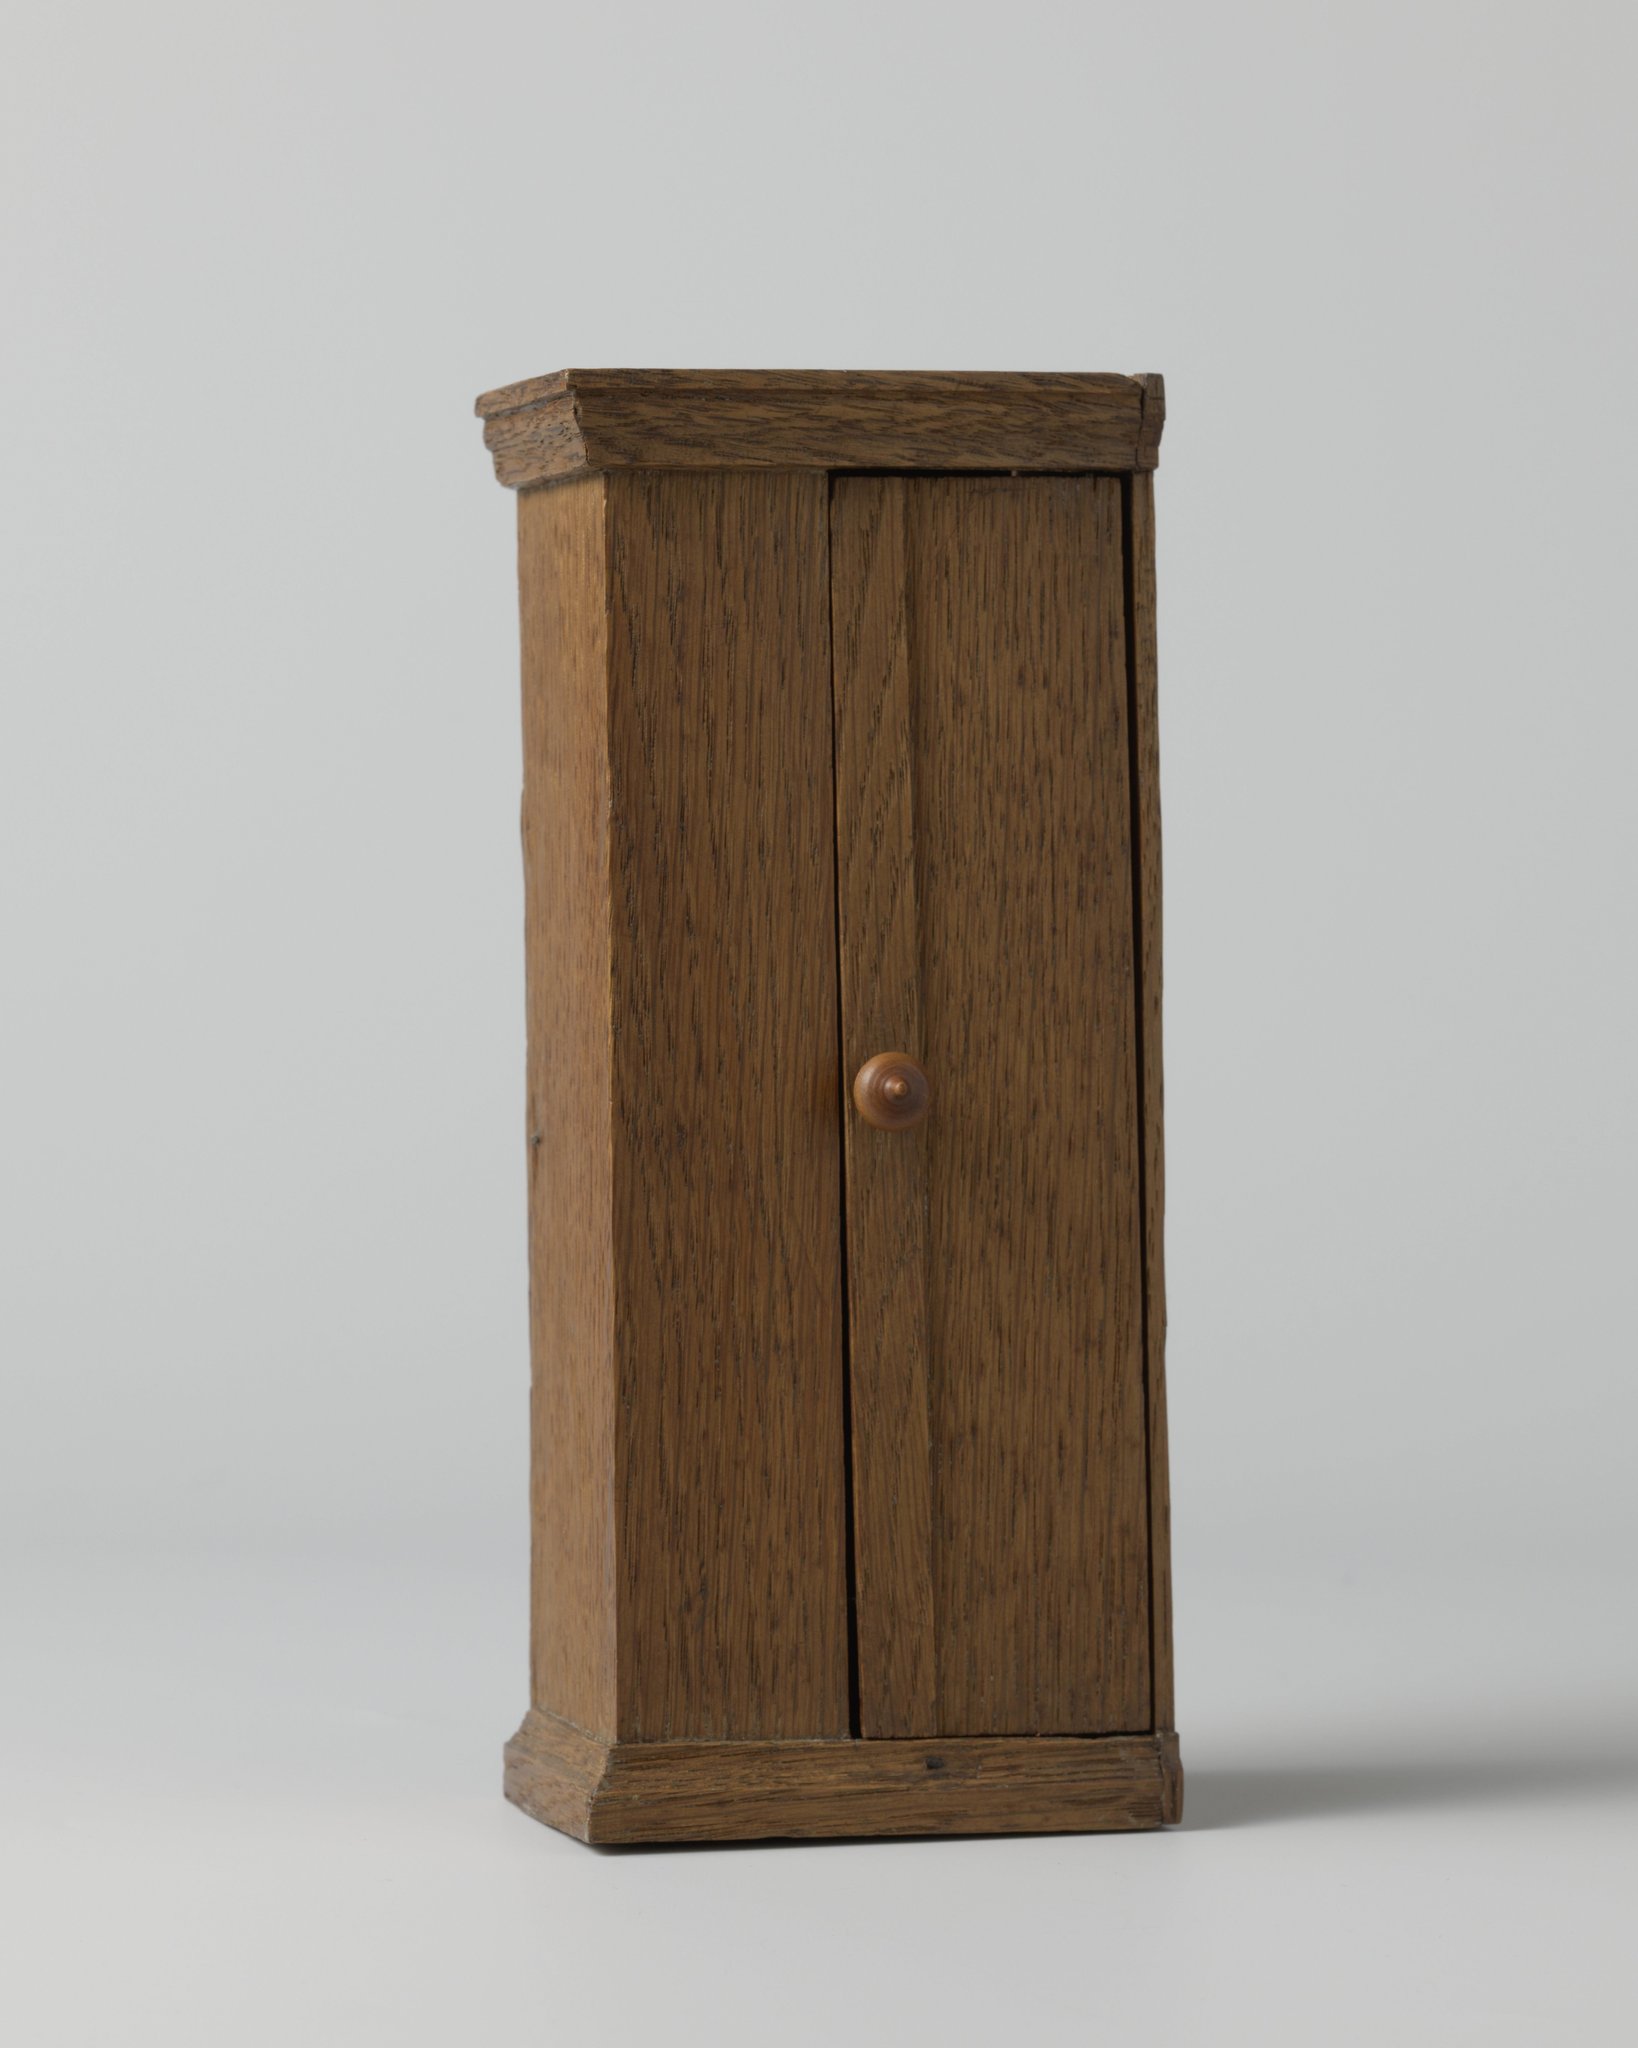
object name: case furniture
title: Klerenkast met één deur, met geprofileerde plint en kap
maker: Anonymous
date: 1750-1800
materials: wood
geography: amsterdam